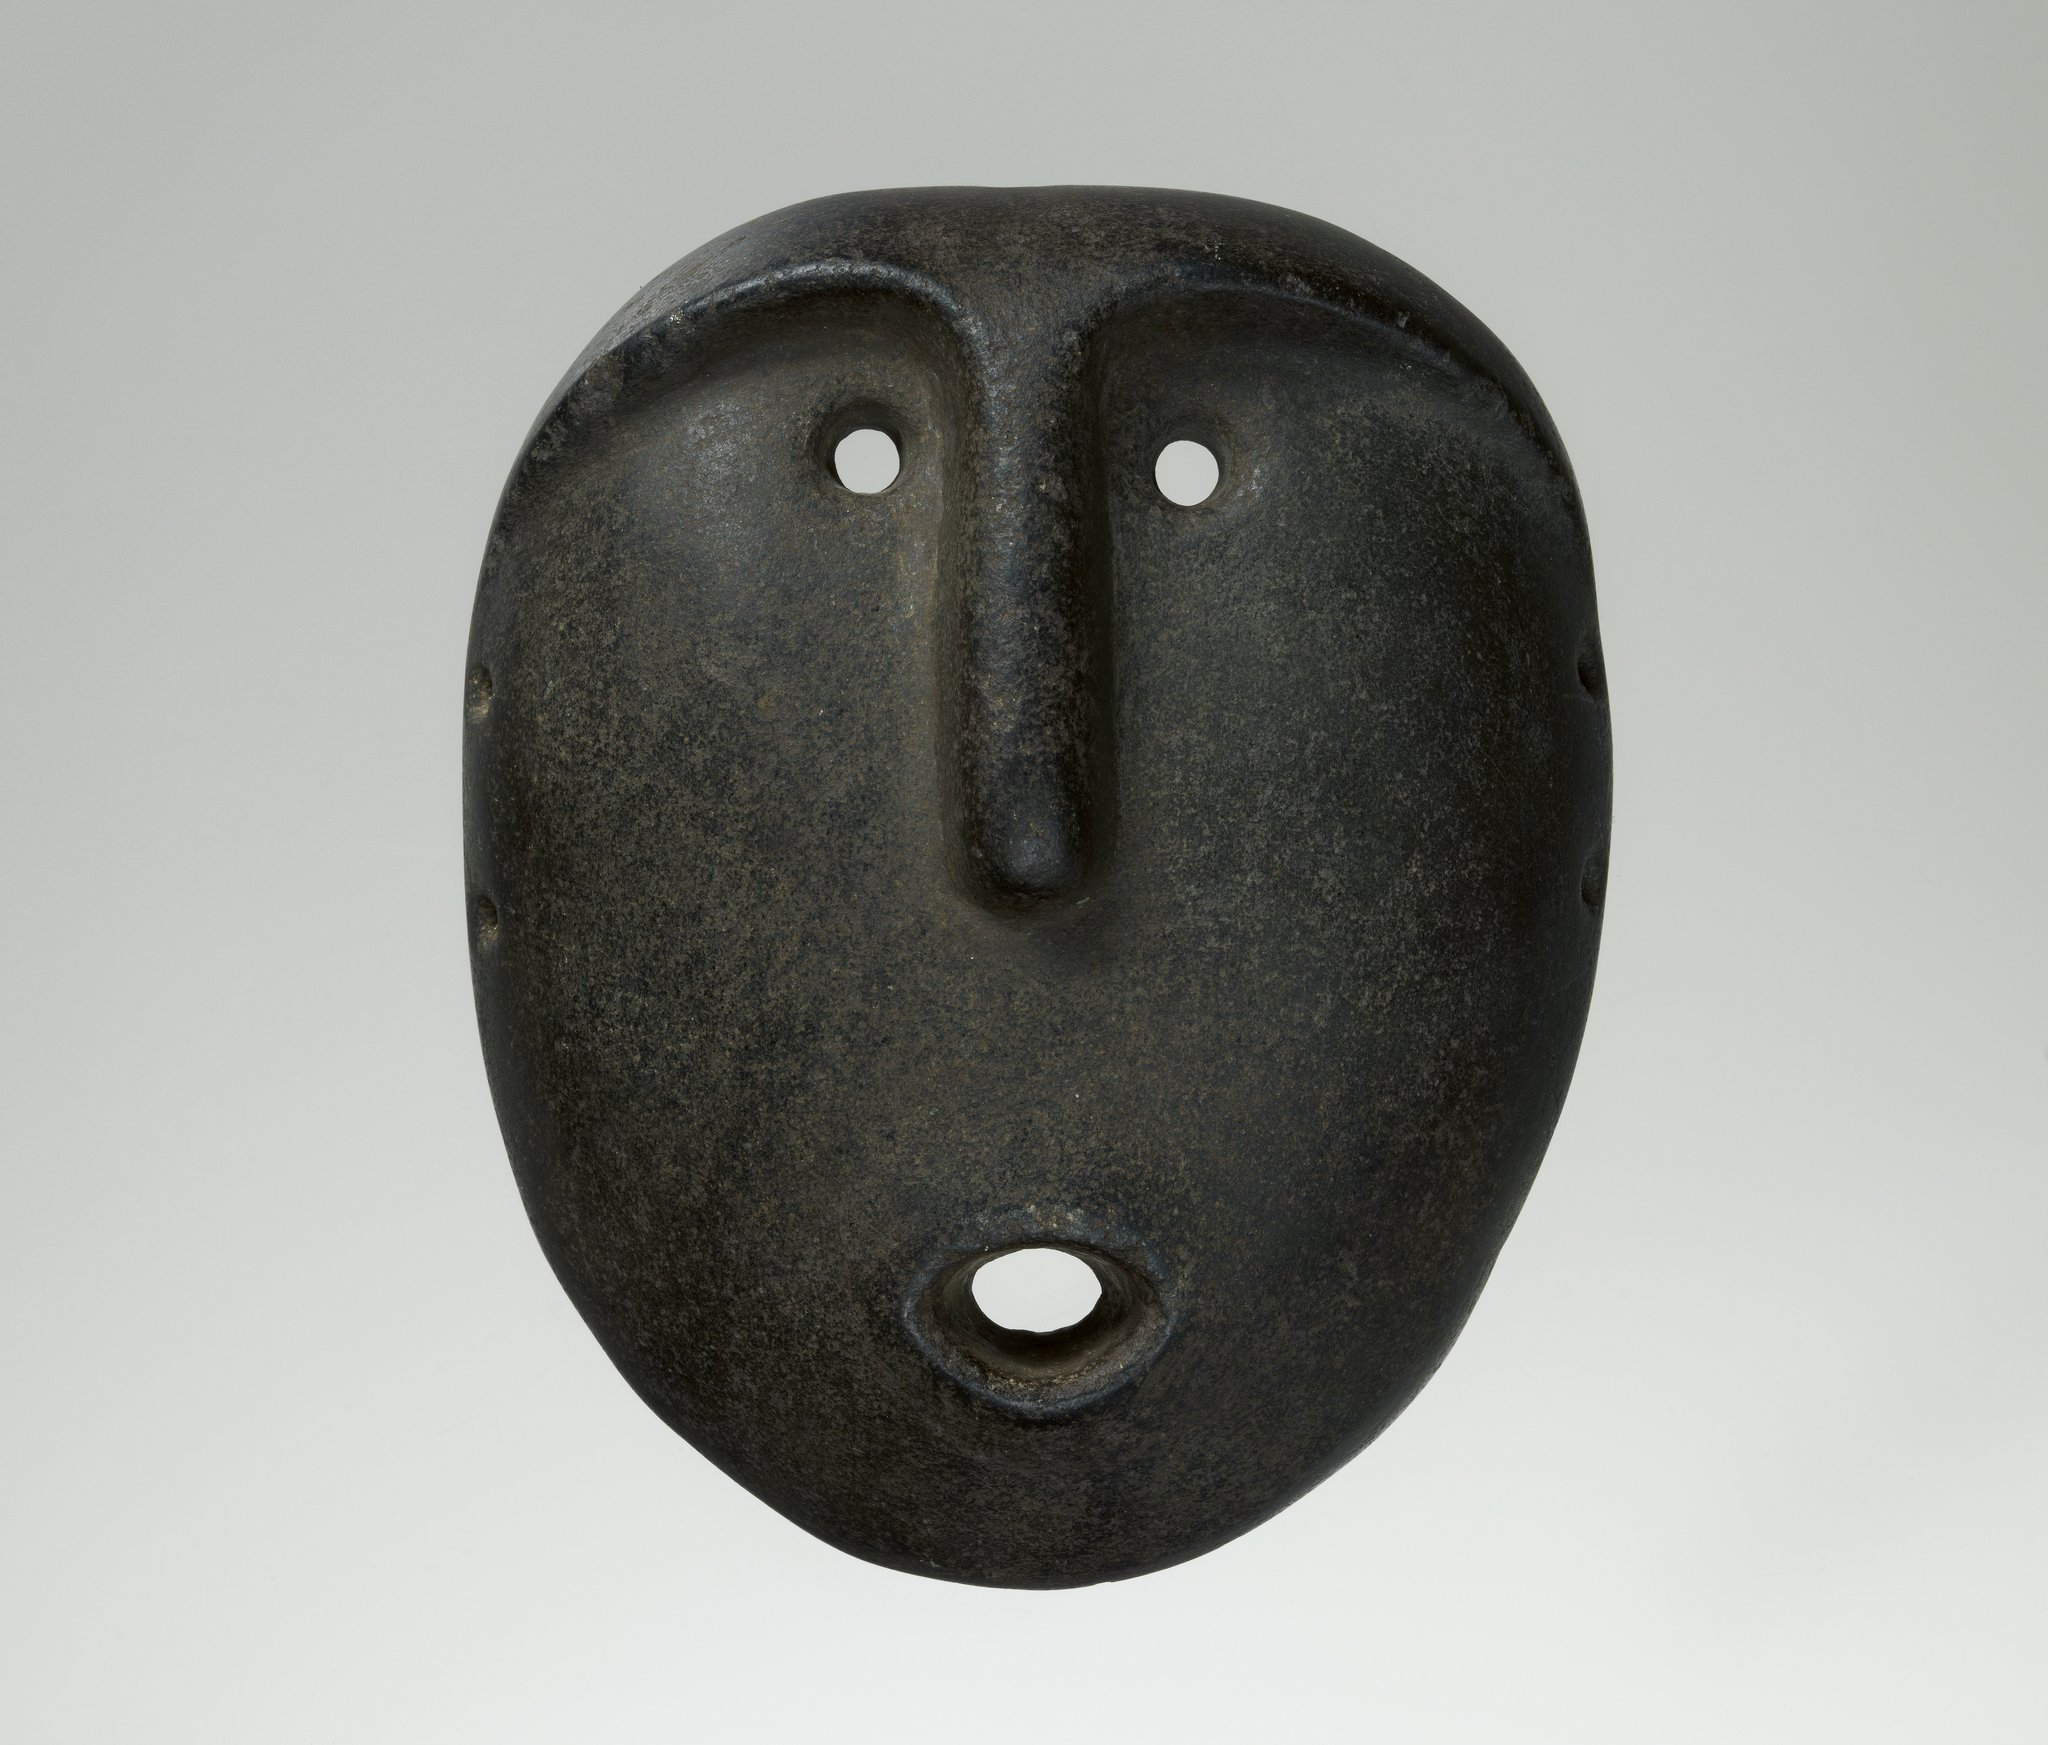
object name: mask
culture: condorhuasi-alamito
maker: condorhuasi-alamito artist(s)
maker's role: artist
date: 400 BCE-500 CE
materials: stone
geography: argentina